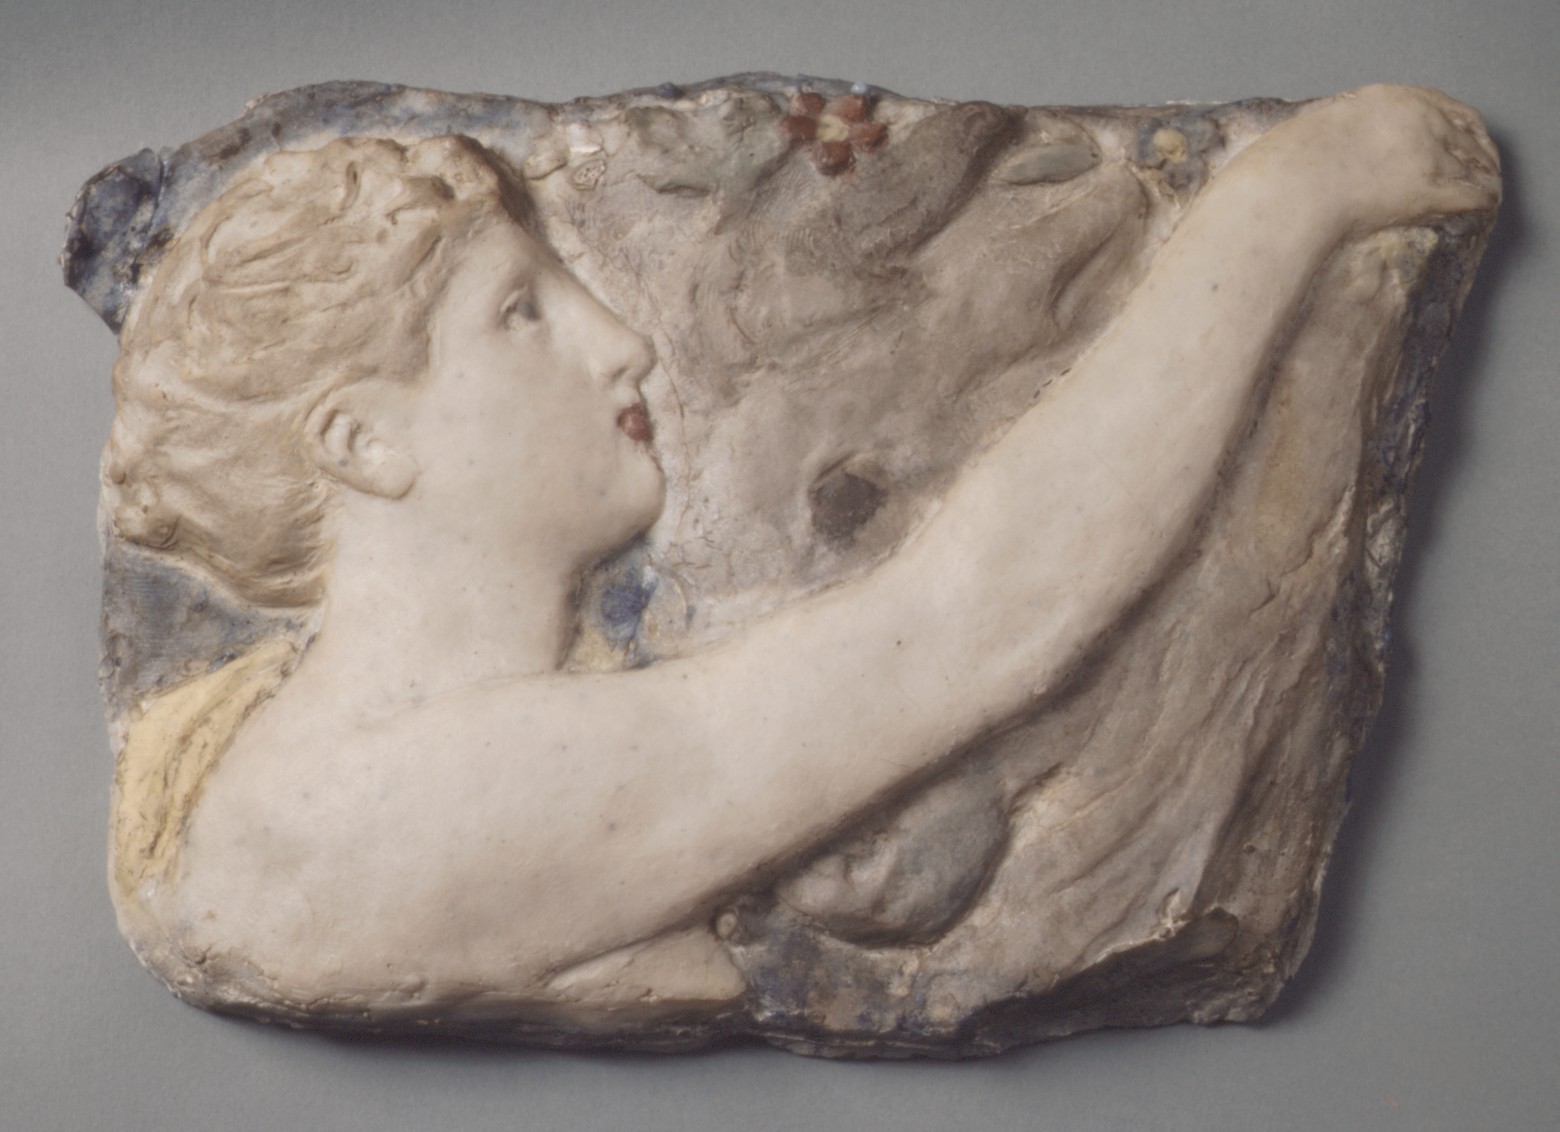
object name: relief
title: Pasiphaë Adorning the Bull with Flowers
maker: césar-isidore-henry cros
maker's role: maker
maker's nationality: french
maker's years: 1840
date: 1891-1907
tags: women,bulls